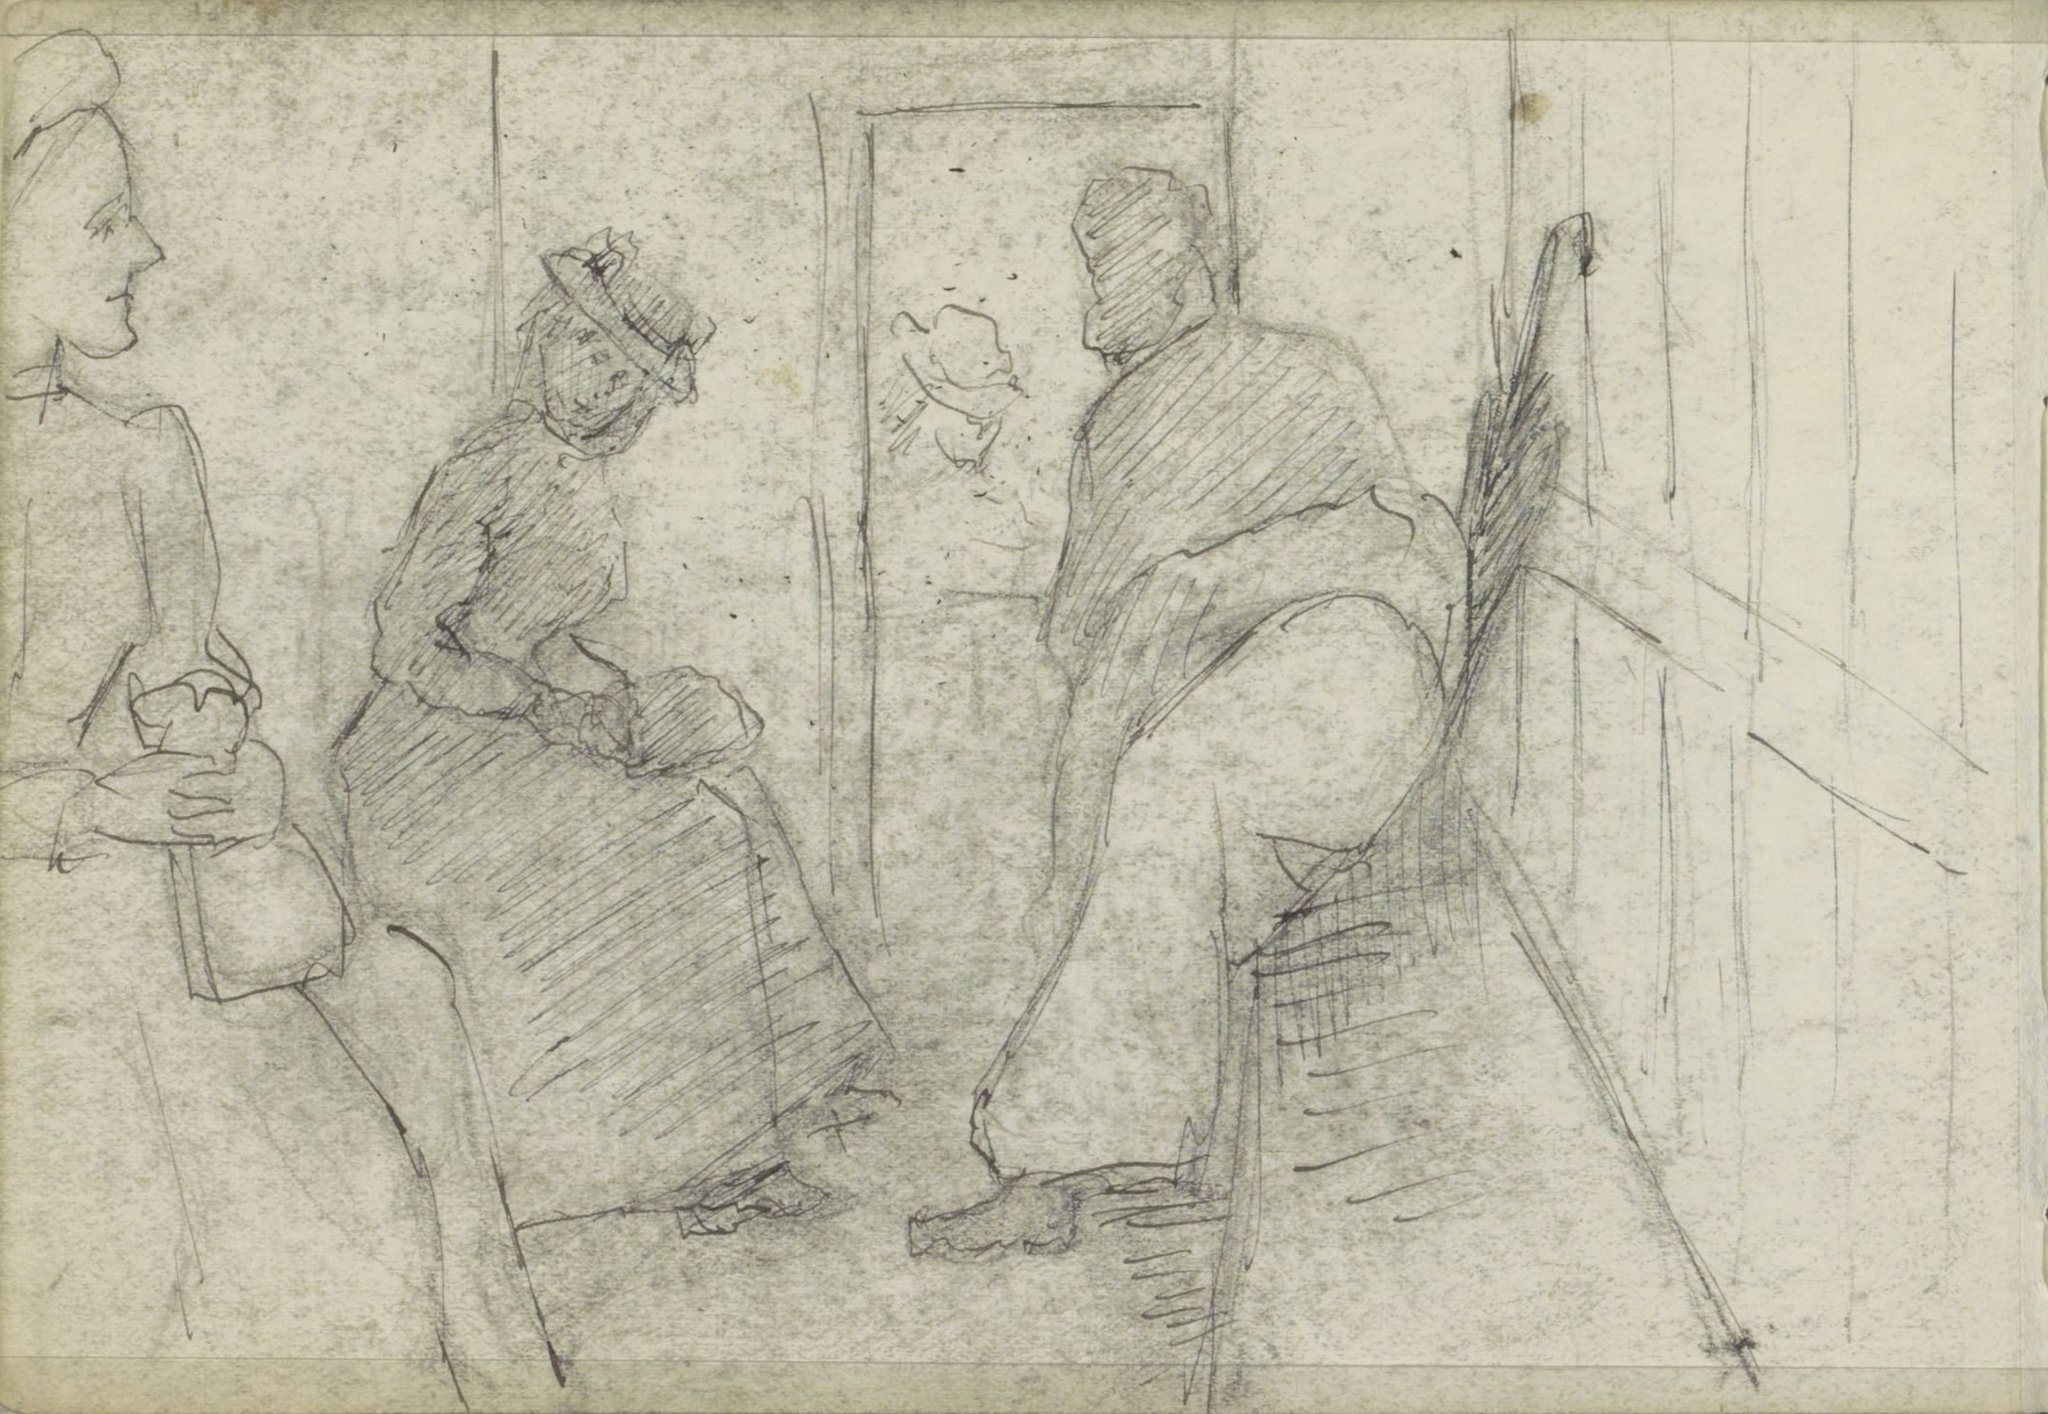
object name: sketchbook leaf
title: Twee zittende vrouwen en een man in een huifkar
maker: jozef israëls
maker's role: draughtsman, painter, print maker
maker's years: 1824-1911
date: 1885-1902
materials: ink, paper, pencil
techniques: pen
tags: sitting figure, covered wagon, hooded wagon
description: Blad 7 verso uit een schetsboek met 17 bladen.